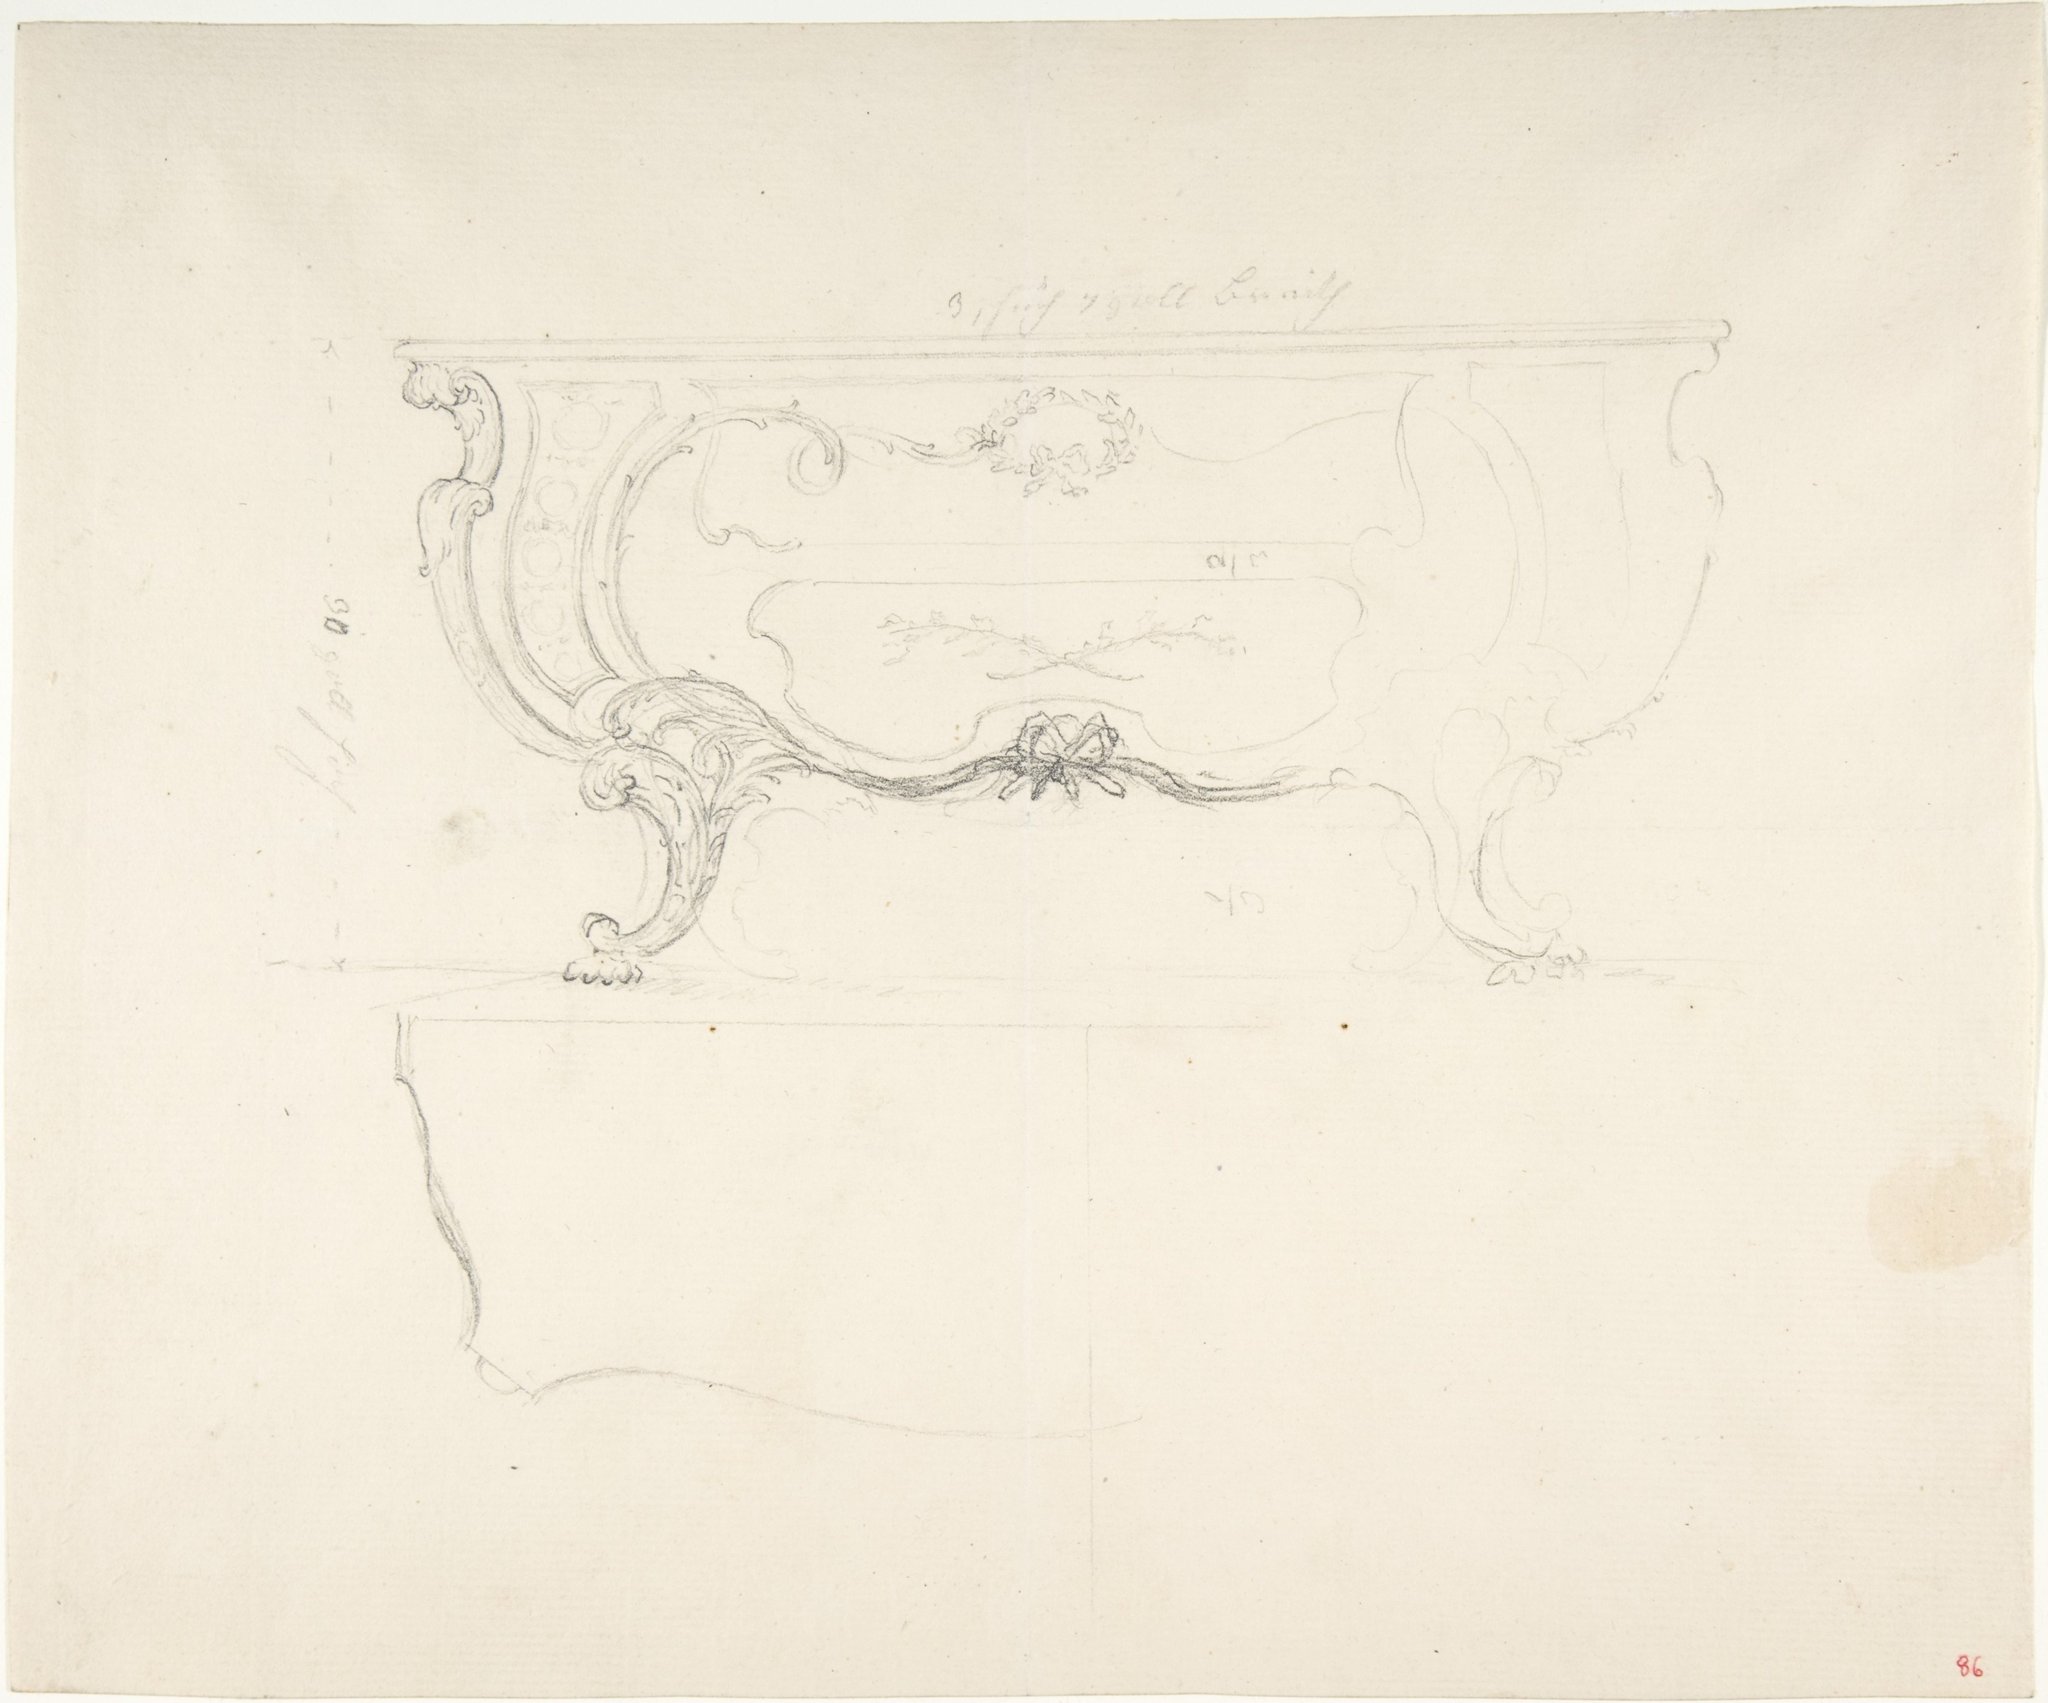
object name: drawing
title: Design for a Chest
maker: anonymous, french, 18th century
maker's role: artist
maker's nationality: french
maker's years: 1700-1800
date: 1770-1790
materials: graphite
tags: chests